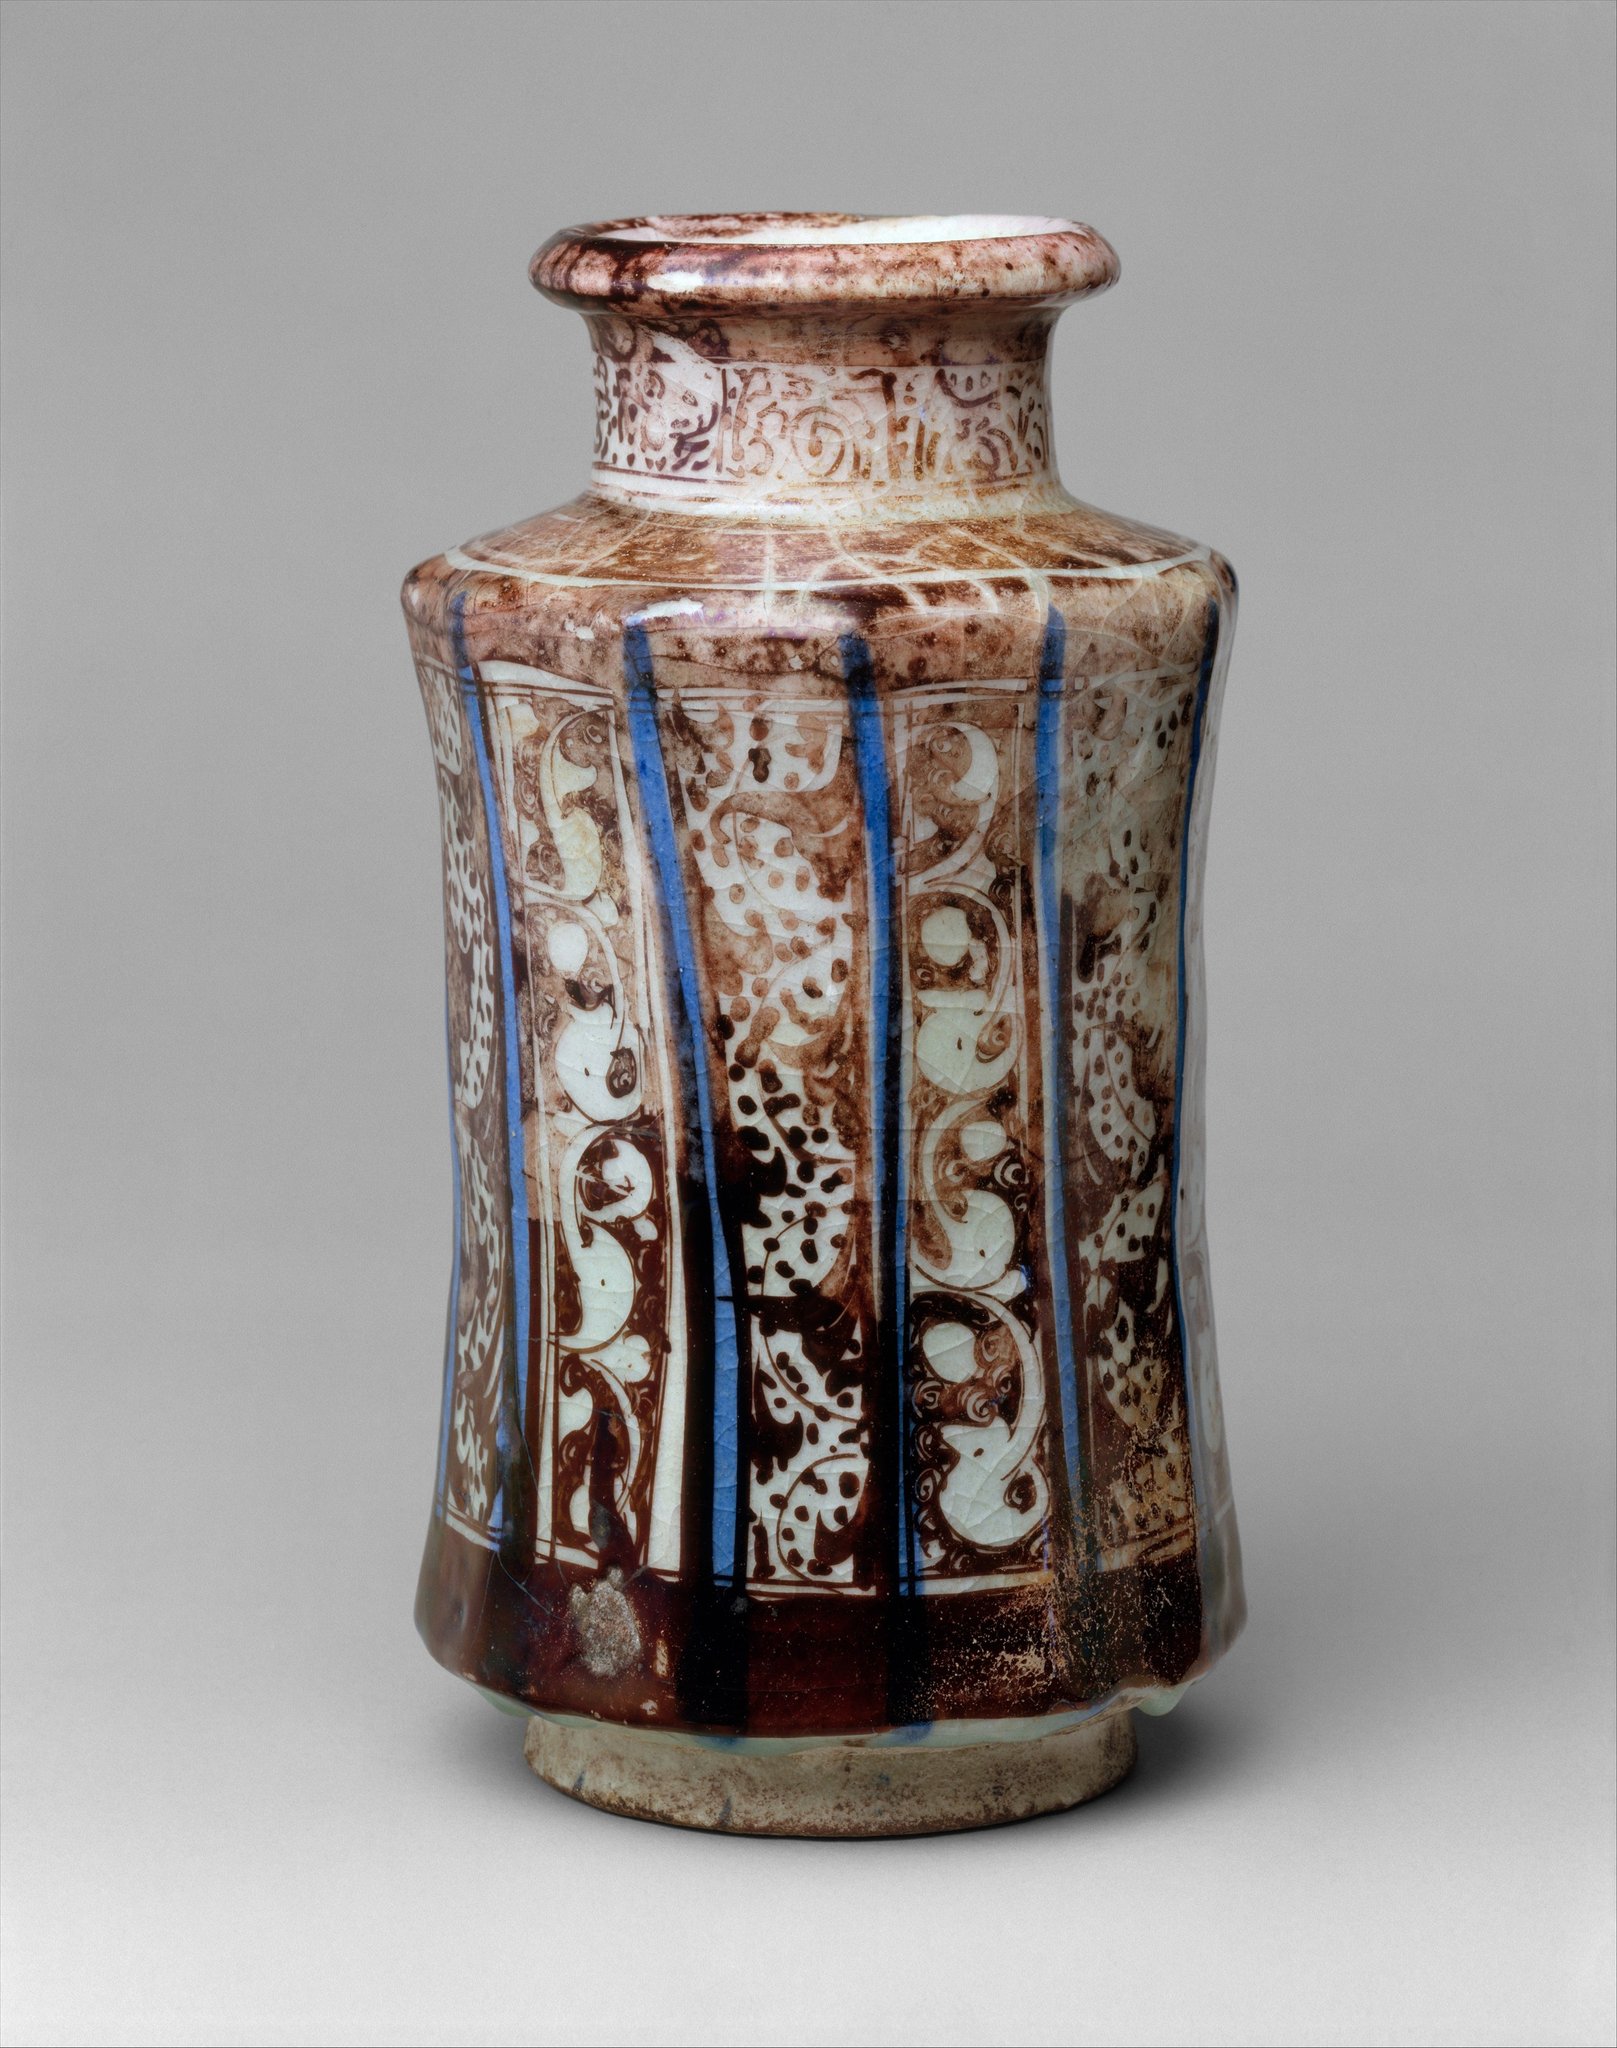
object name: jar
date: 1101-1300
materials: glaze, stonepaste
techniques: painting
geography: syria